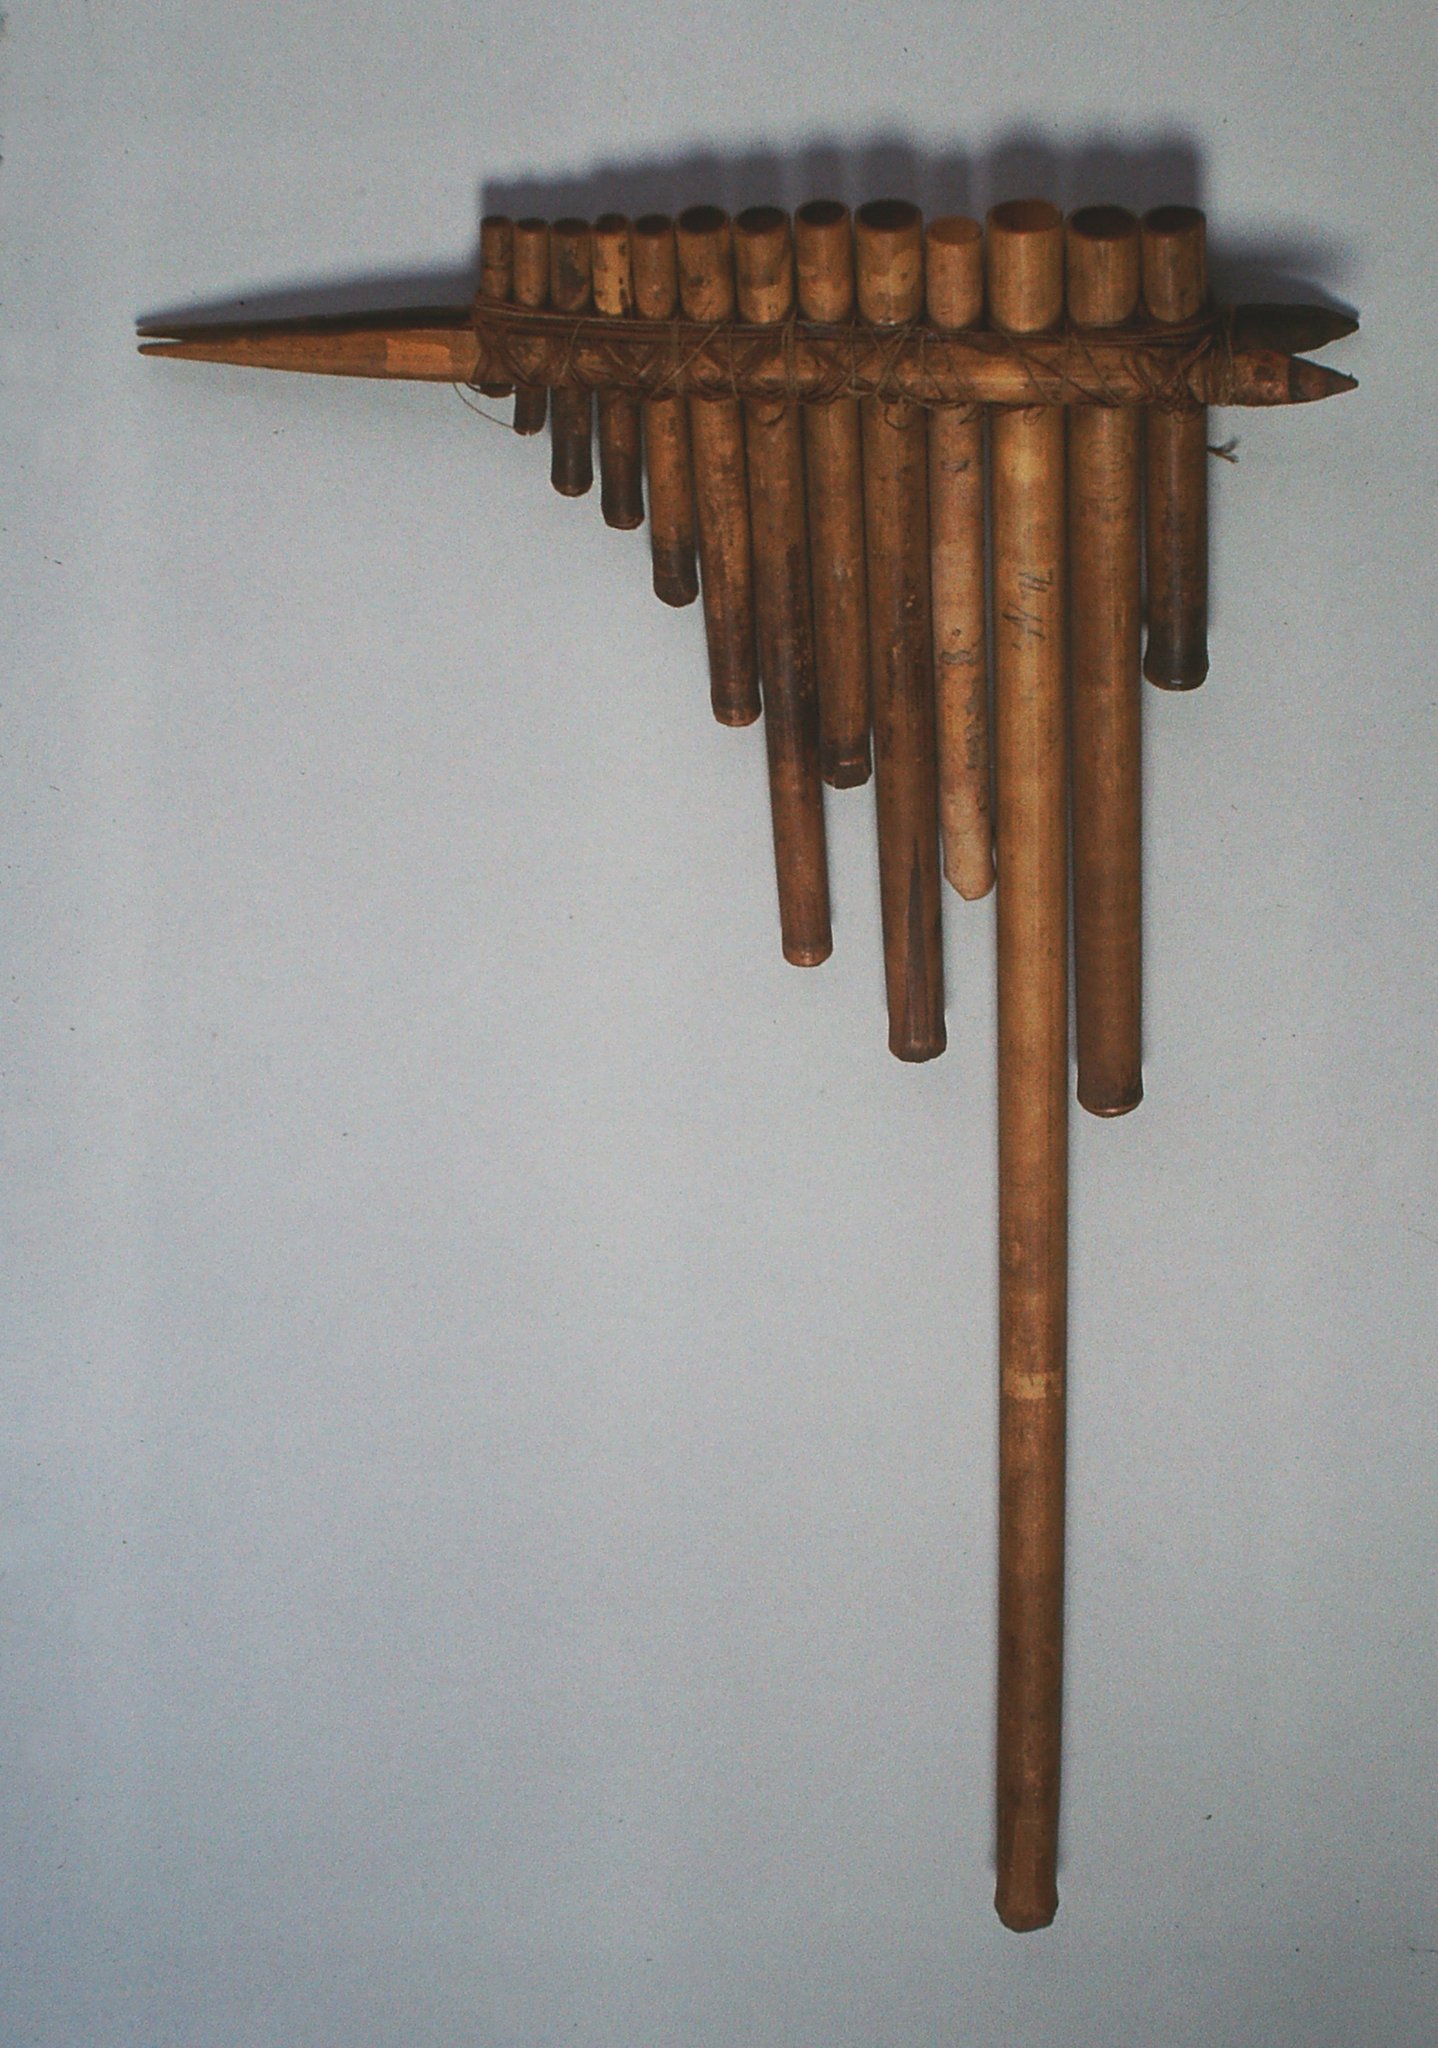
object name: galeon hohamumu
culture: melanesian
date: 1867-1900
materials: bamboo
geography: solomon islands